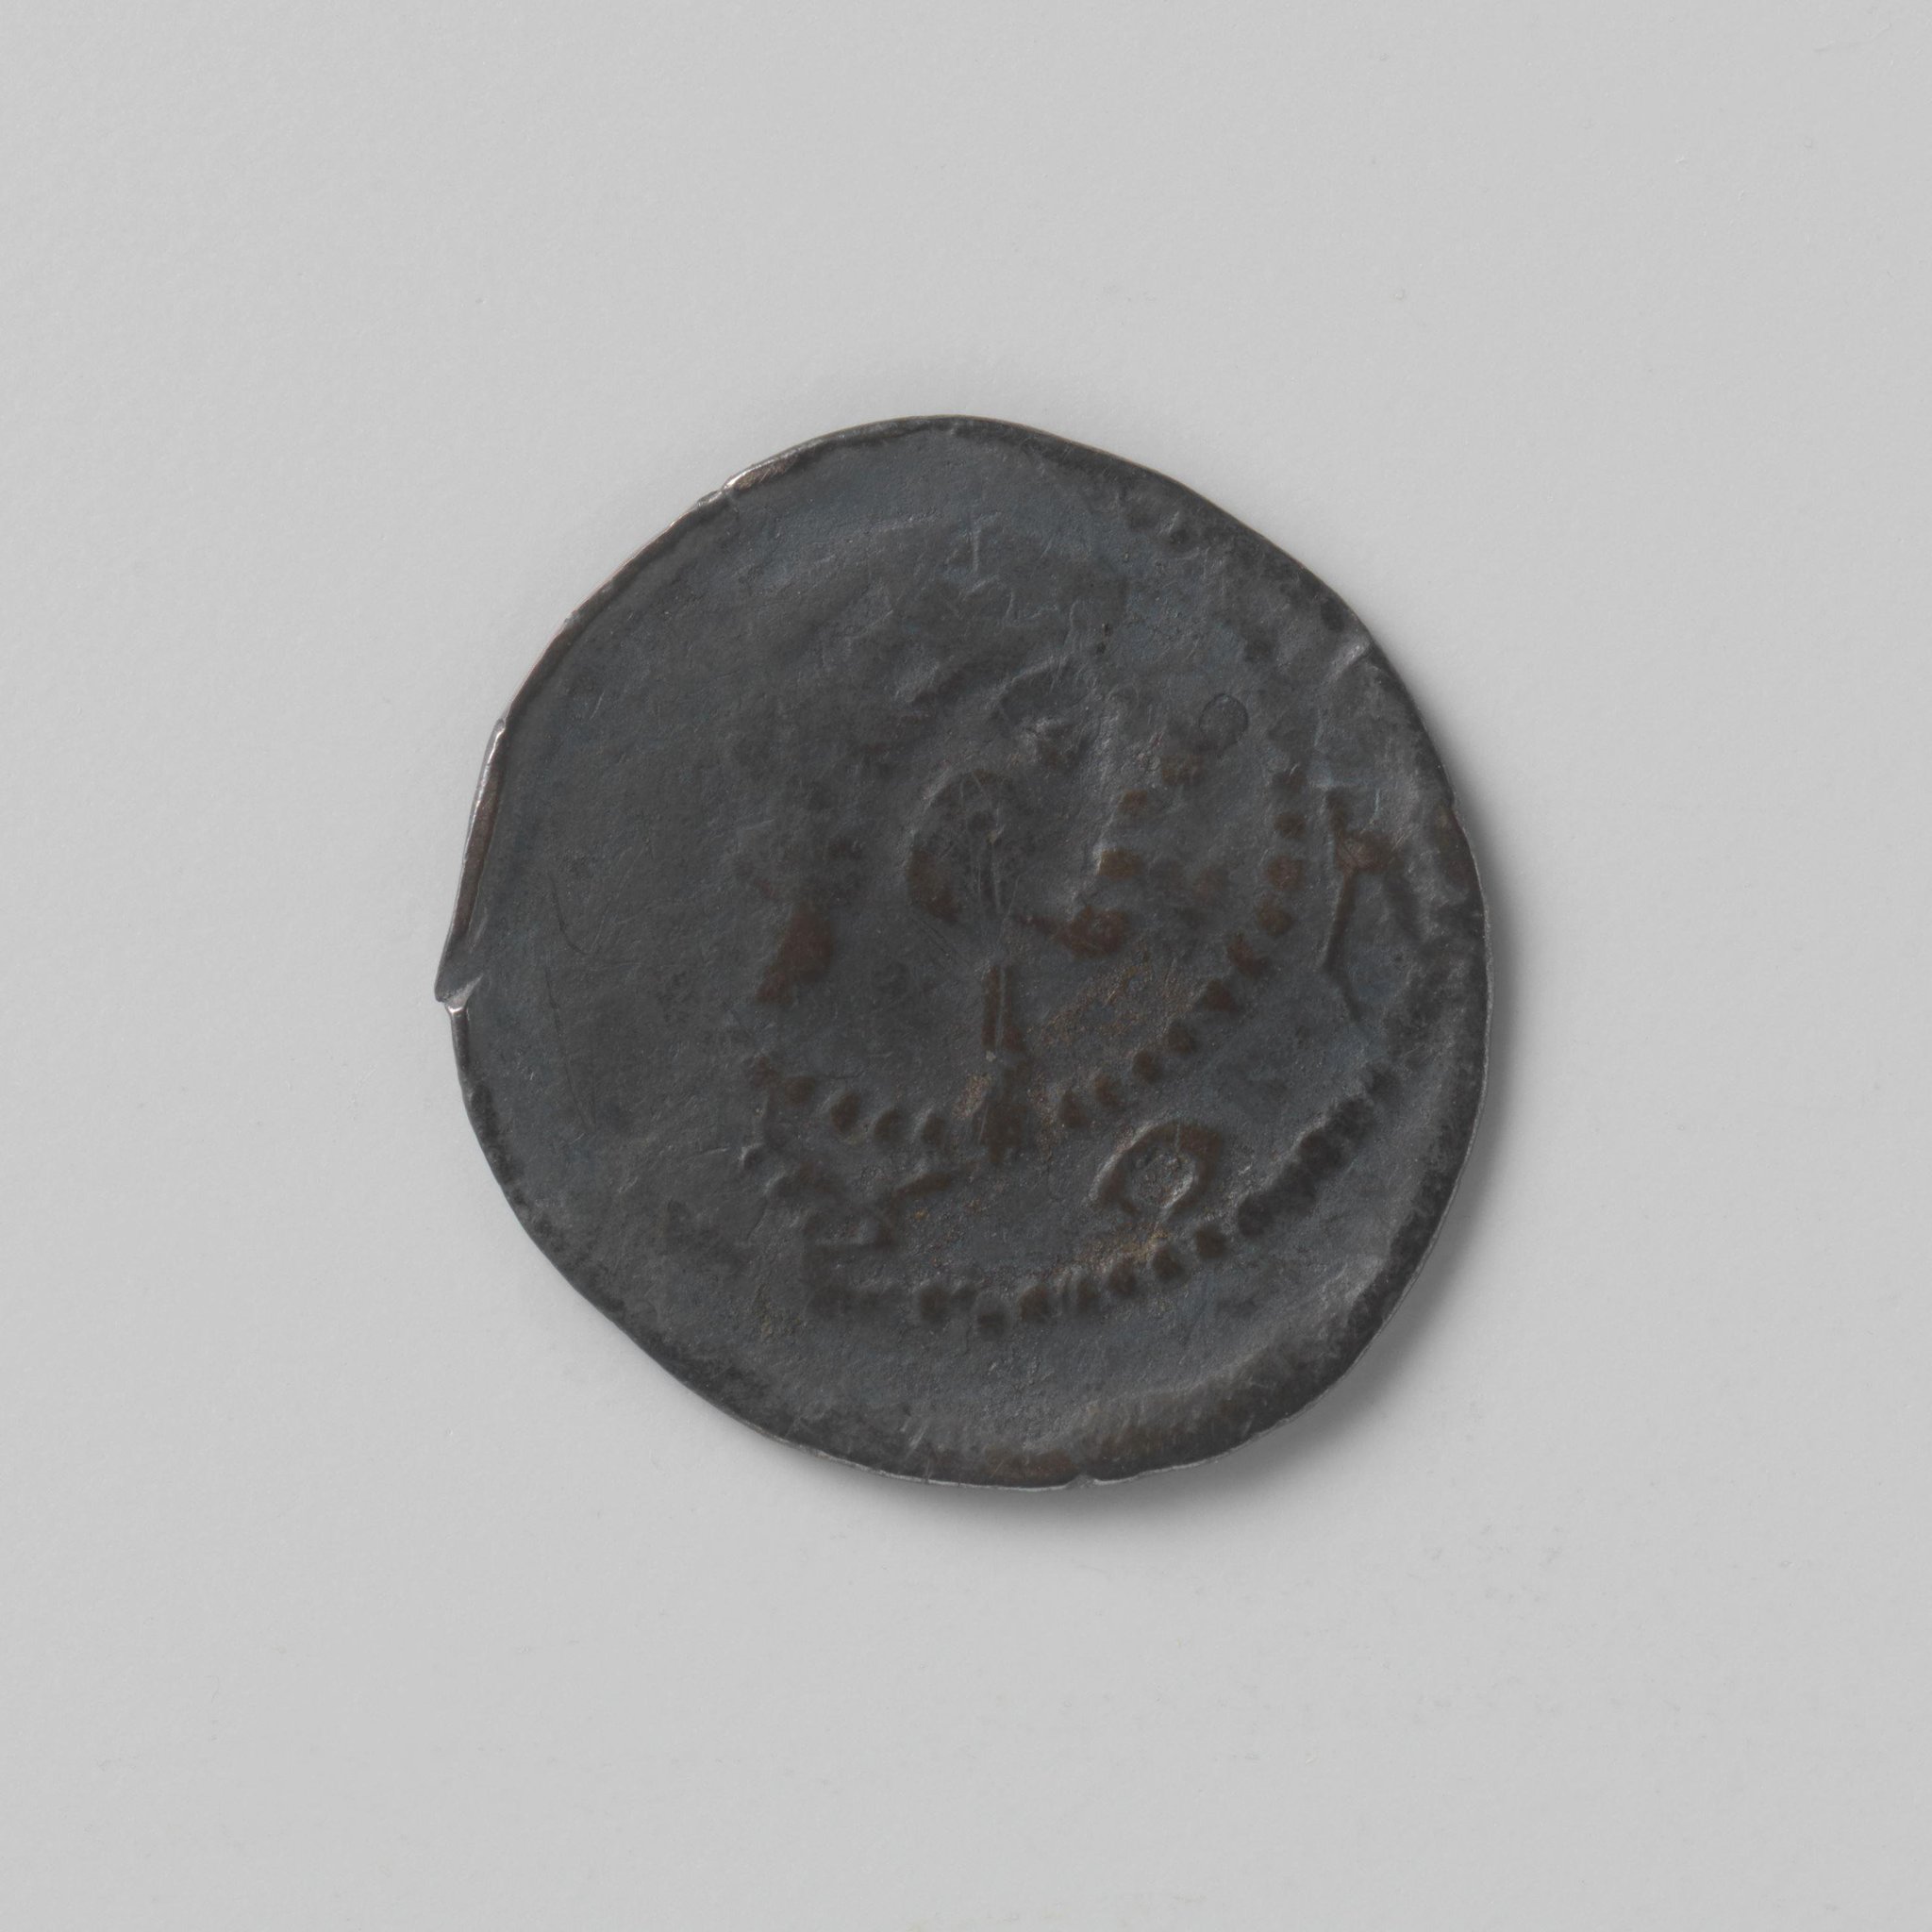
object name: coin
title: Hollandse penning van Floris V, 1256-1296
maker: floris v (graaf van holland en zeeland)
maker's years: 1254-1296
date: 1256-1258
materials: silver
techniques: striking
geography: dordrecht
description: Zilveren munt. Voorzijde: hoofd met gravenmuts naar rechts. Keerzijde: lang dubbellijnig kruis.